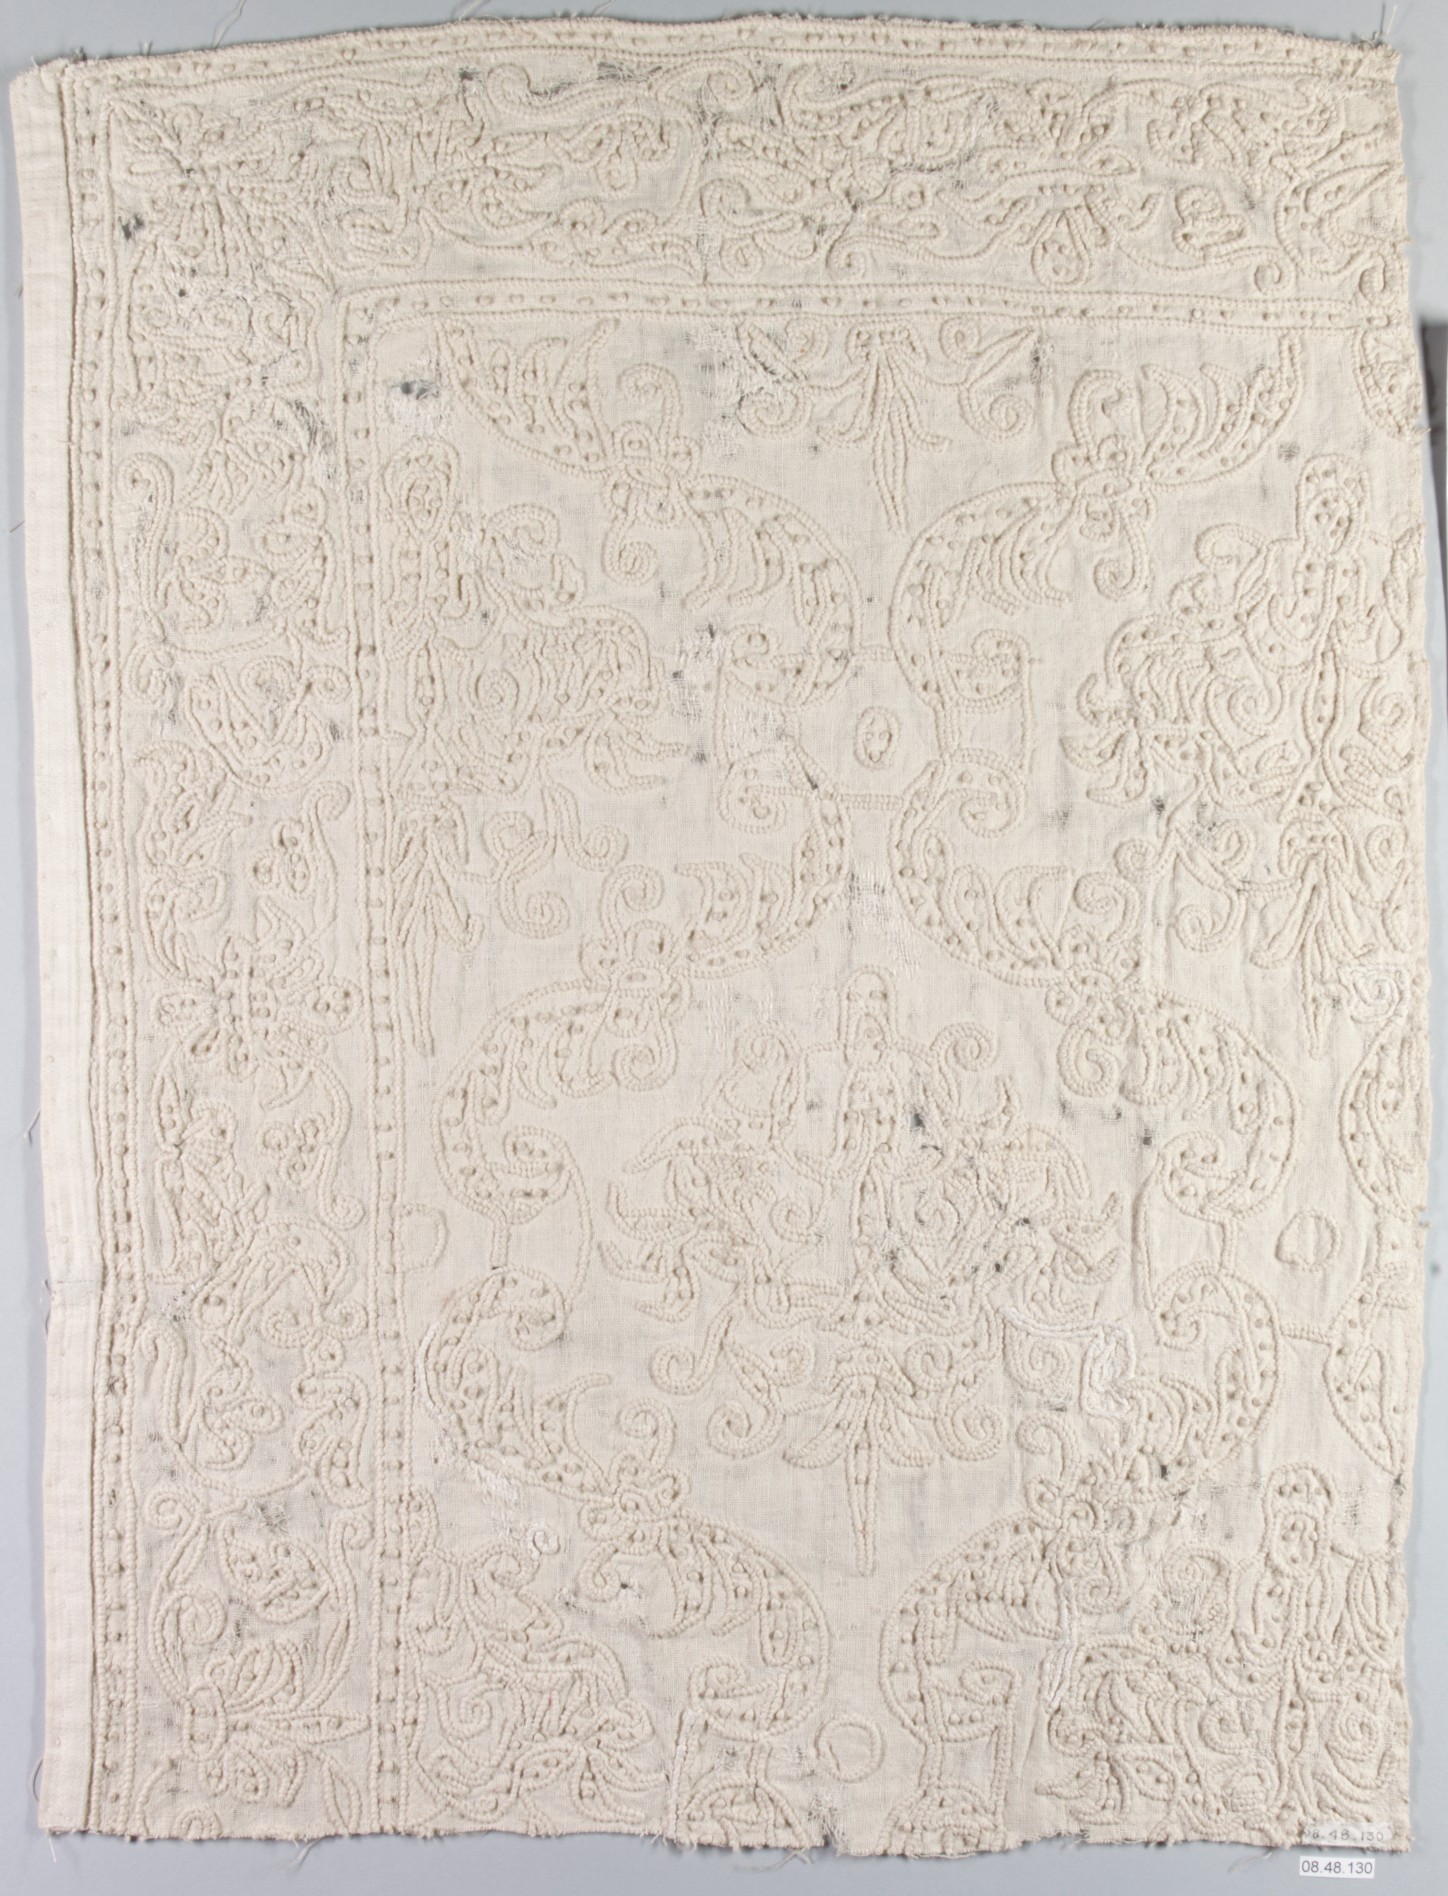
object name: fragment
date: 1600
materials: linen